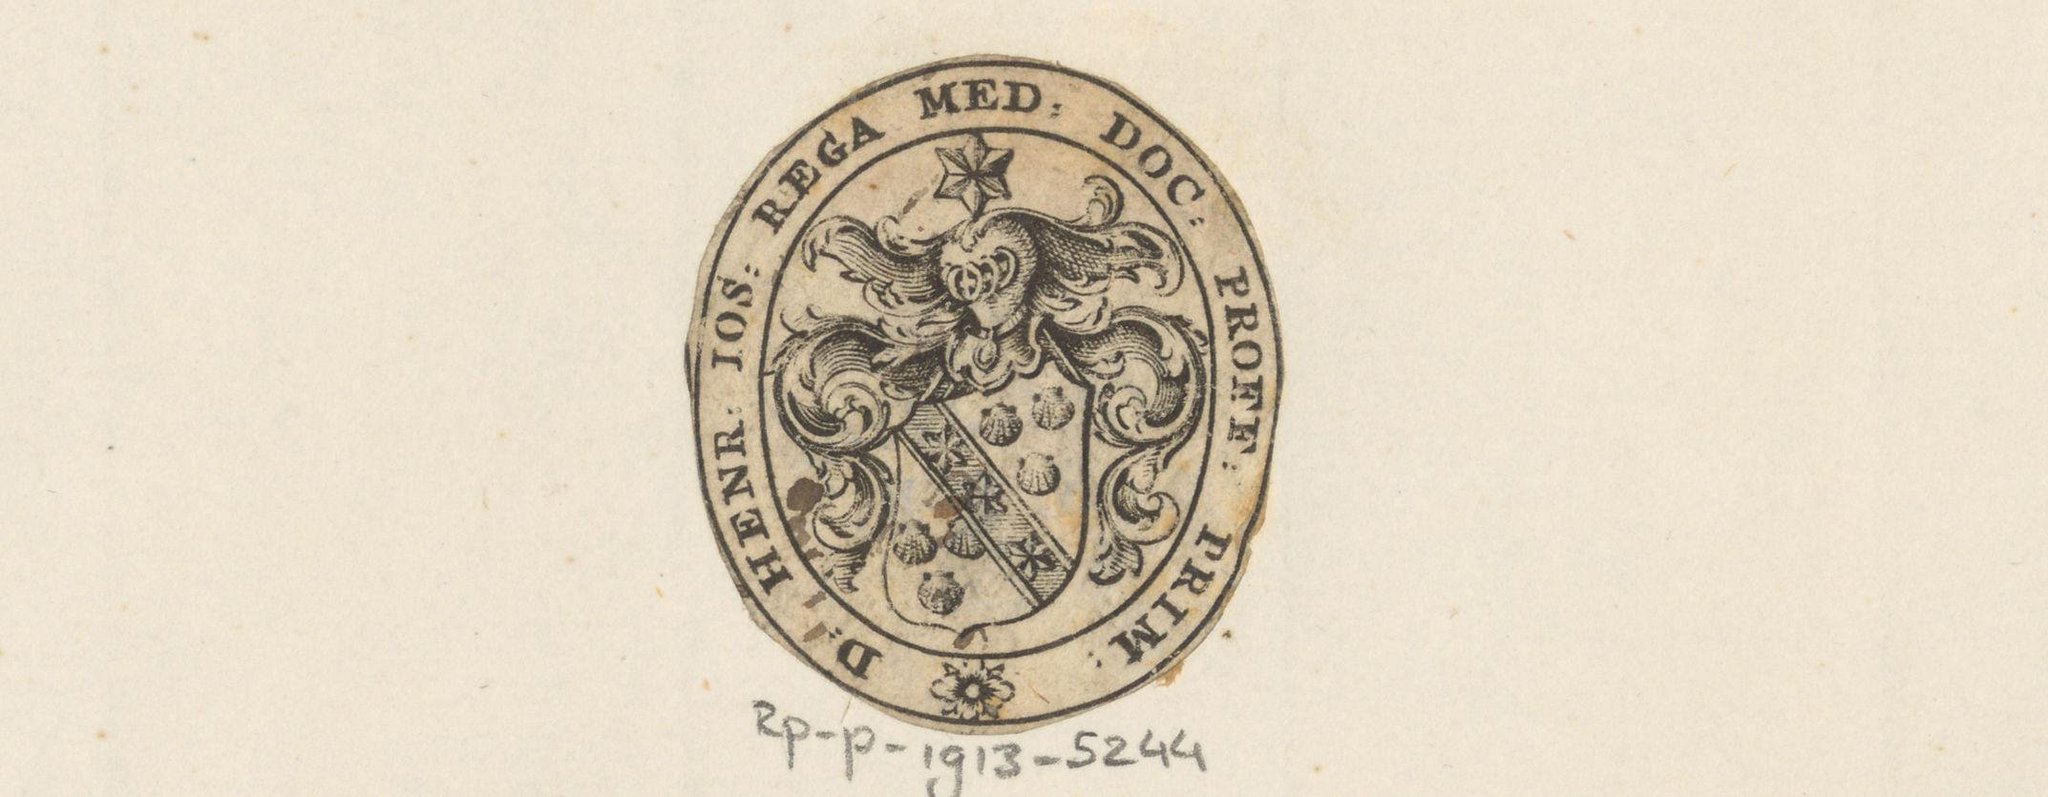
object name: bookplate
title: Ex libris van D. Henr. Ios. Rega Med. Doc. Proff. Prim.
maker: Anonymous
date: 1700-1799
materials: paper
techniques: engraving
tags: armorial bearing, heraldry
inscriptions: collector's mark: Lugt 2760, collector's mark: Lugt 2233